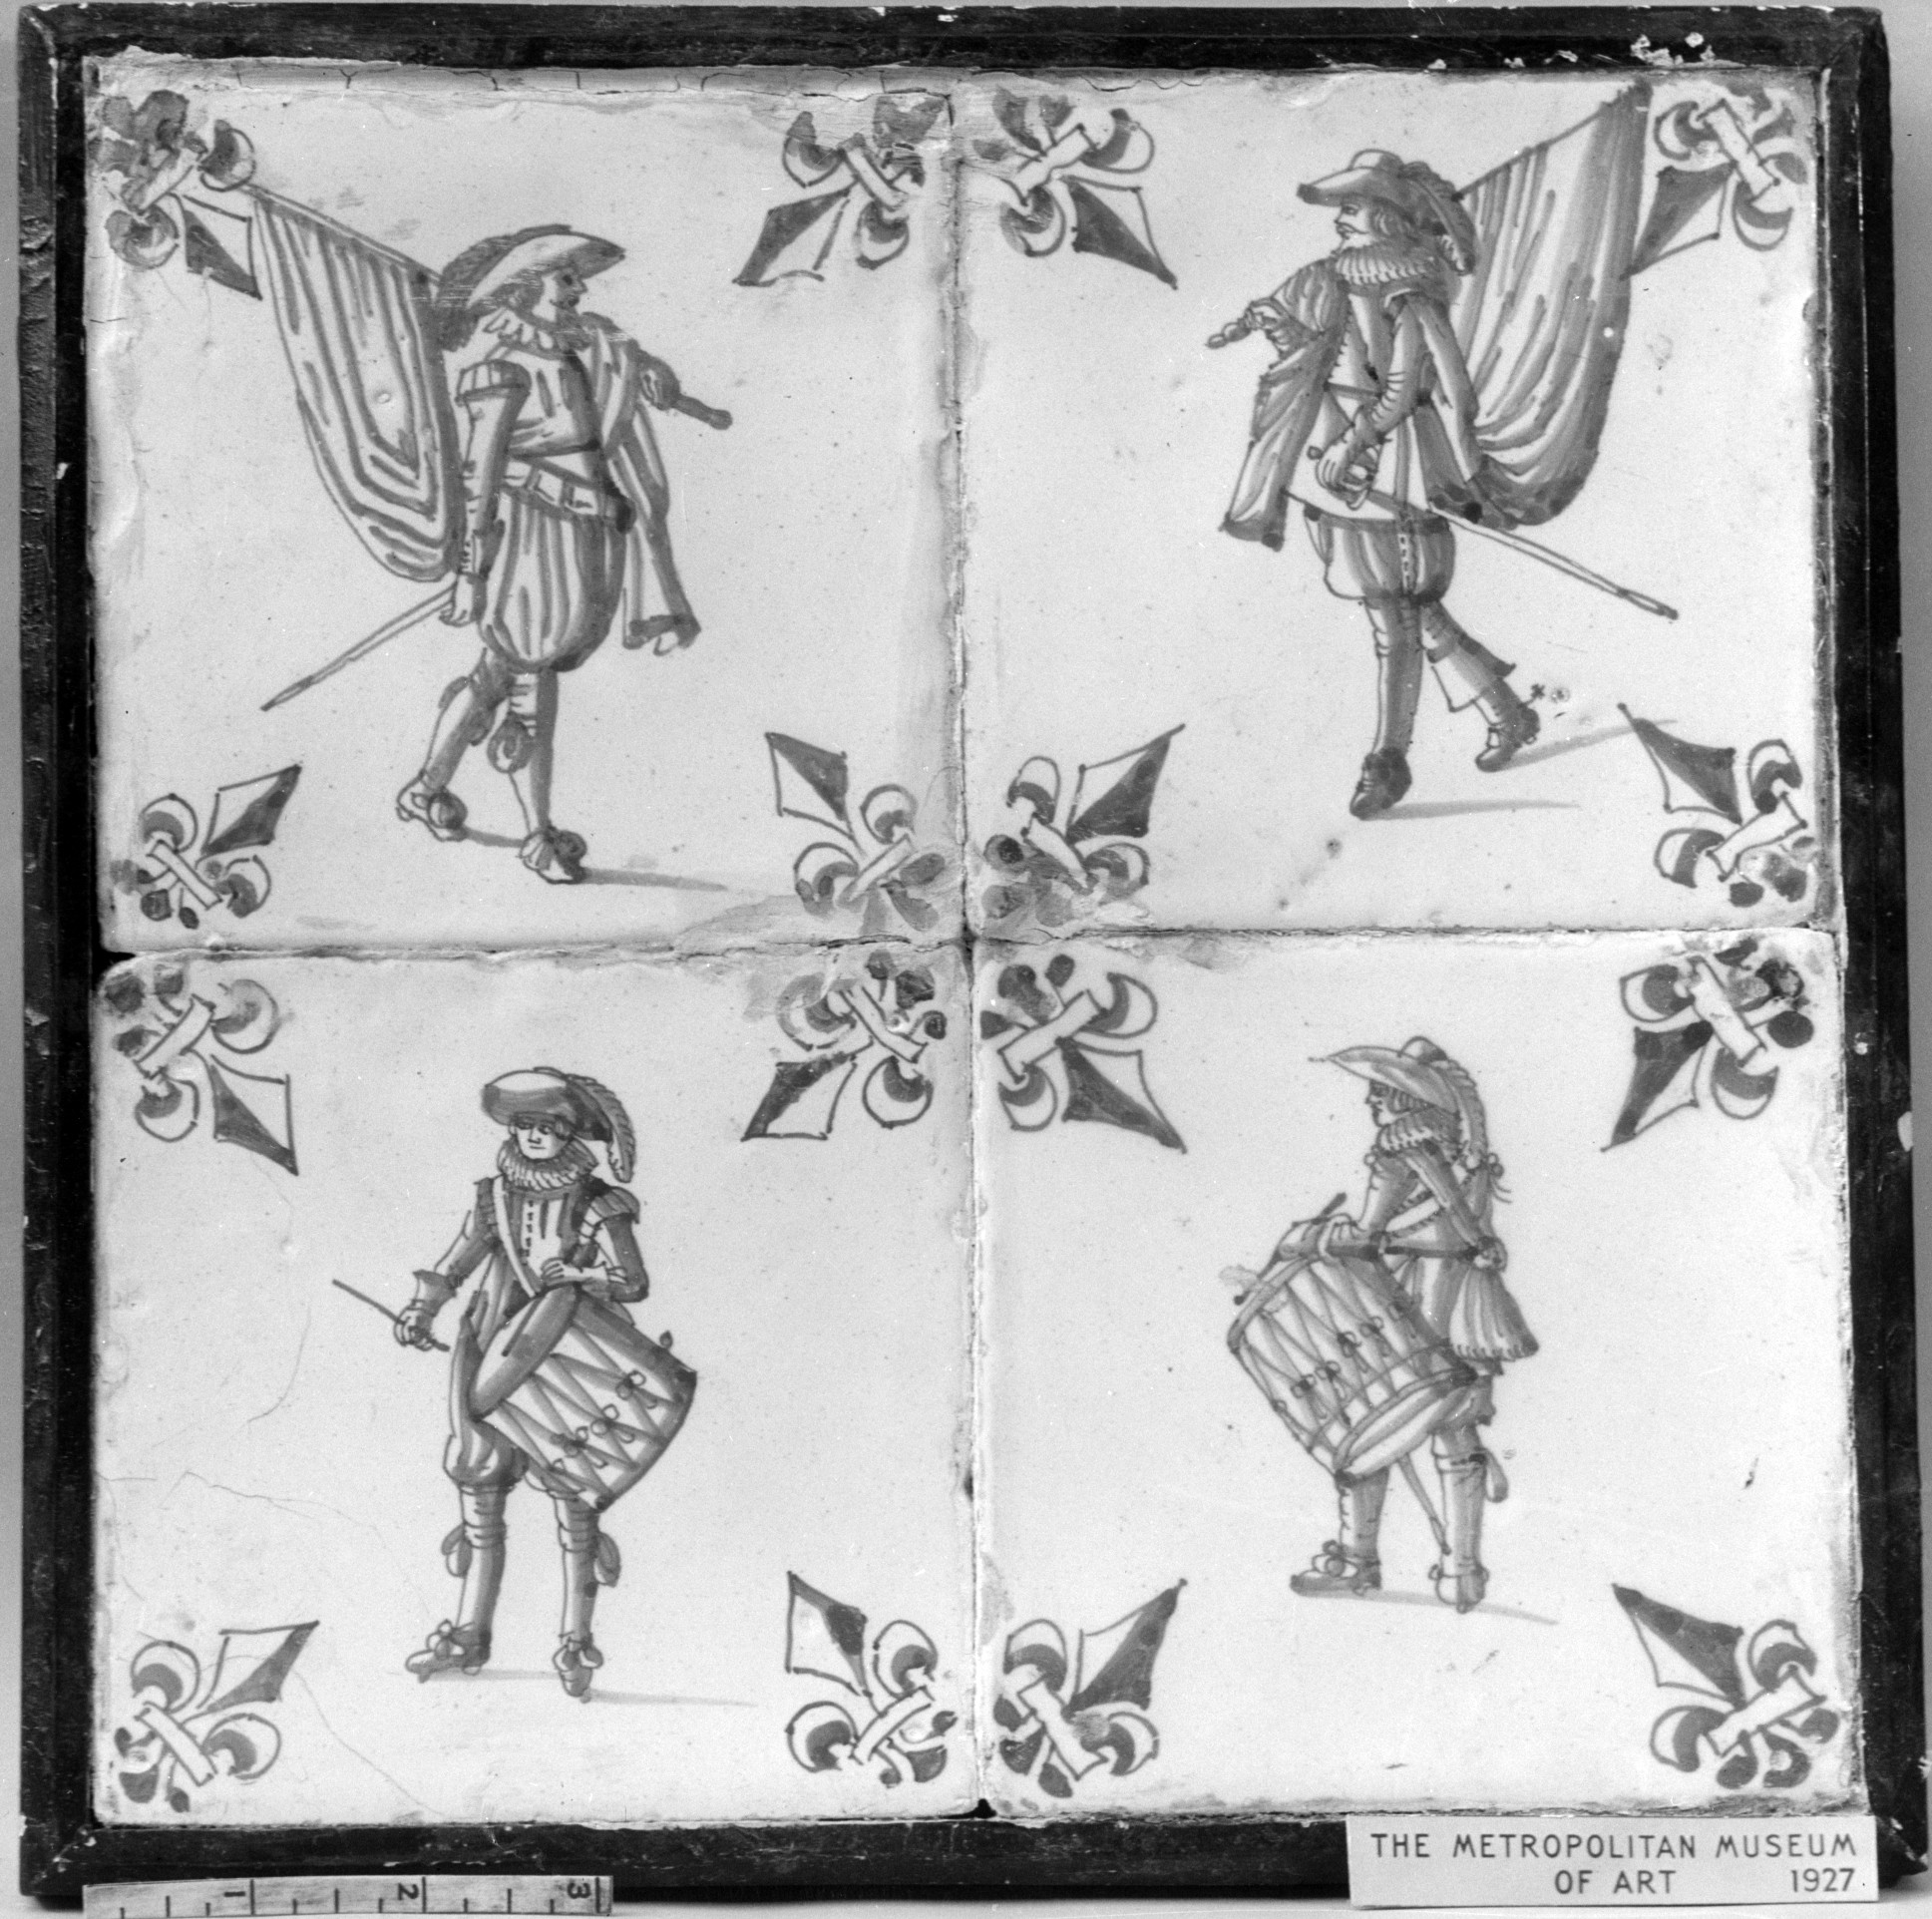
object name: tile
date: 1801-1900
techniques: glazing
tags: swords,men,drums